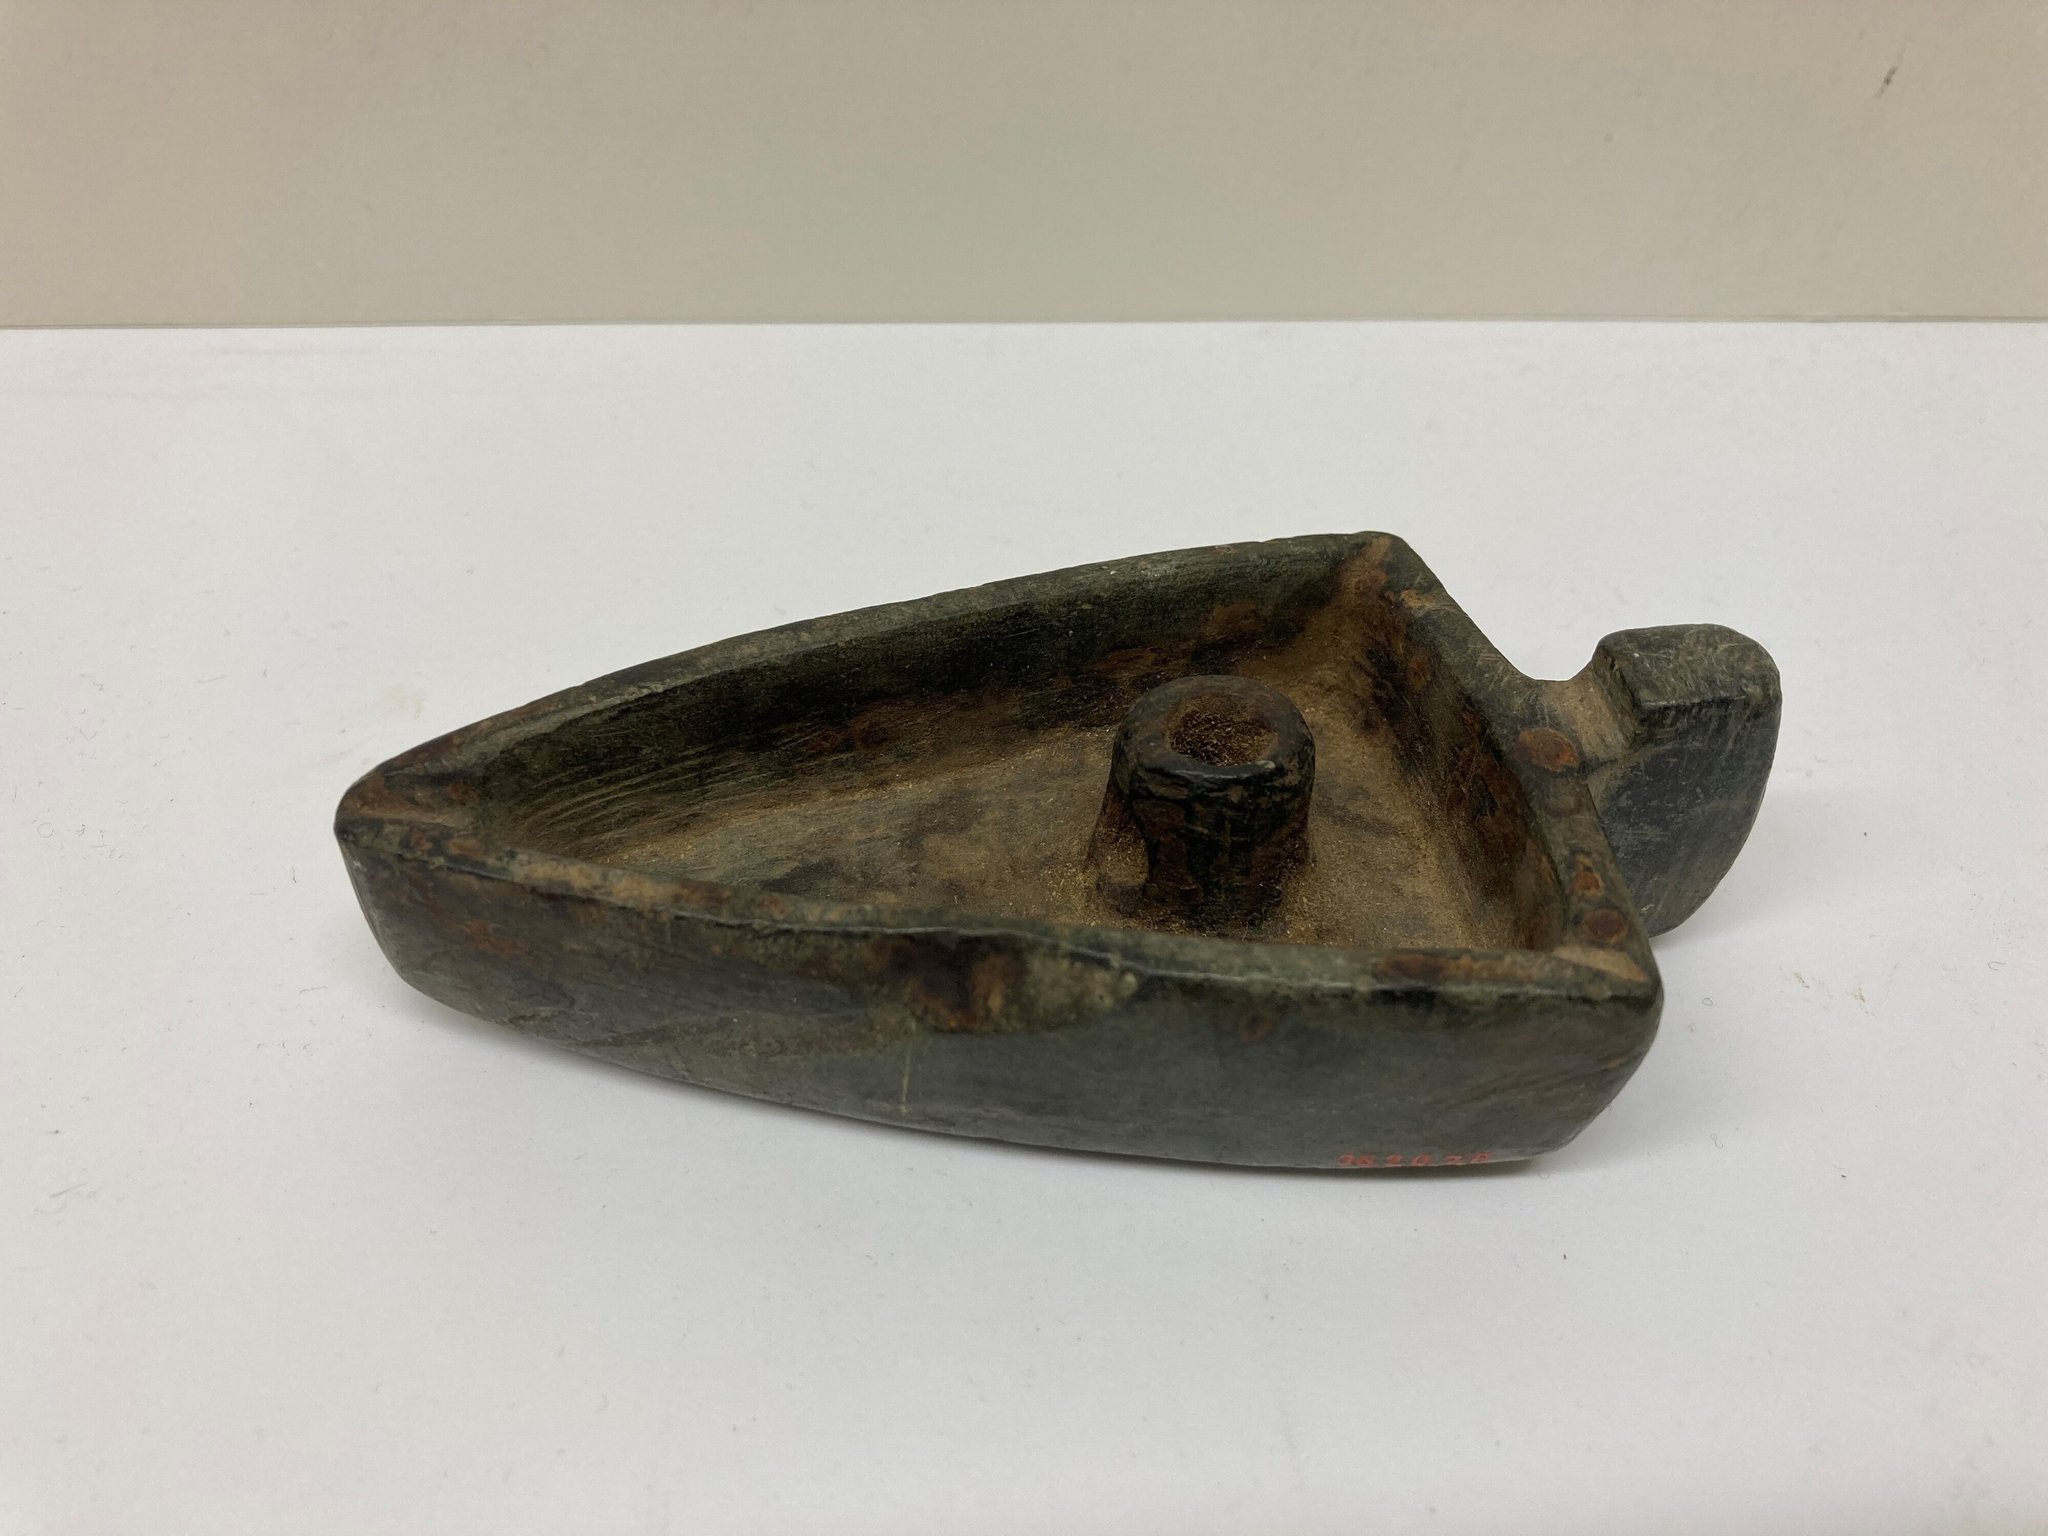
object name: lamp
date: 901-1000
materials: stone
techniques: carving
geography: iran